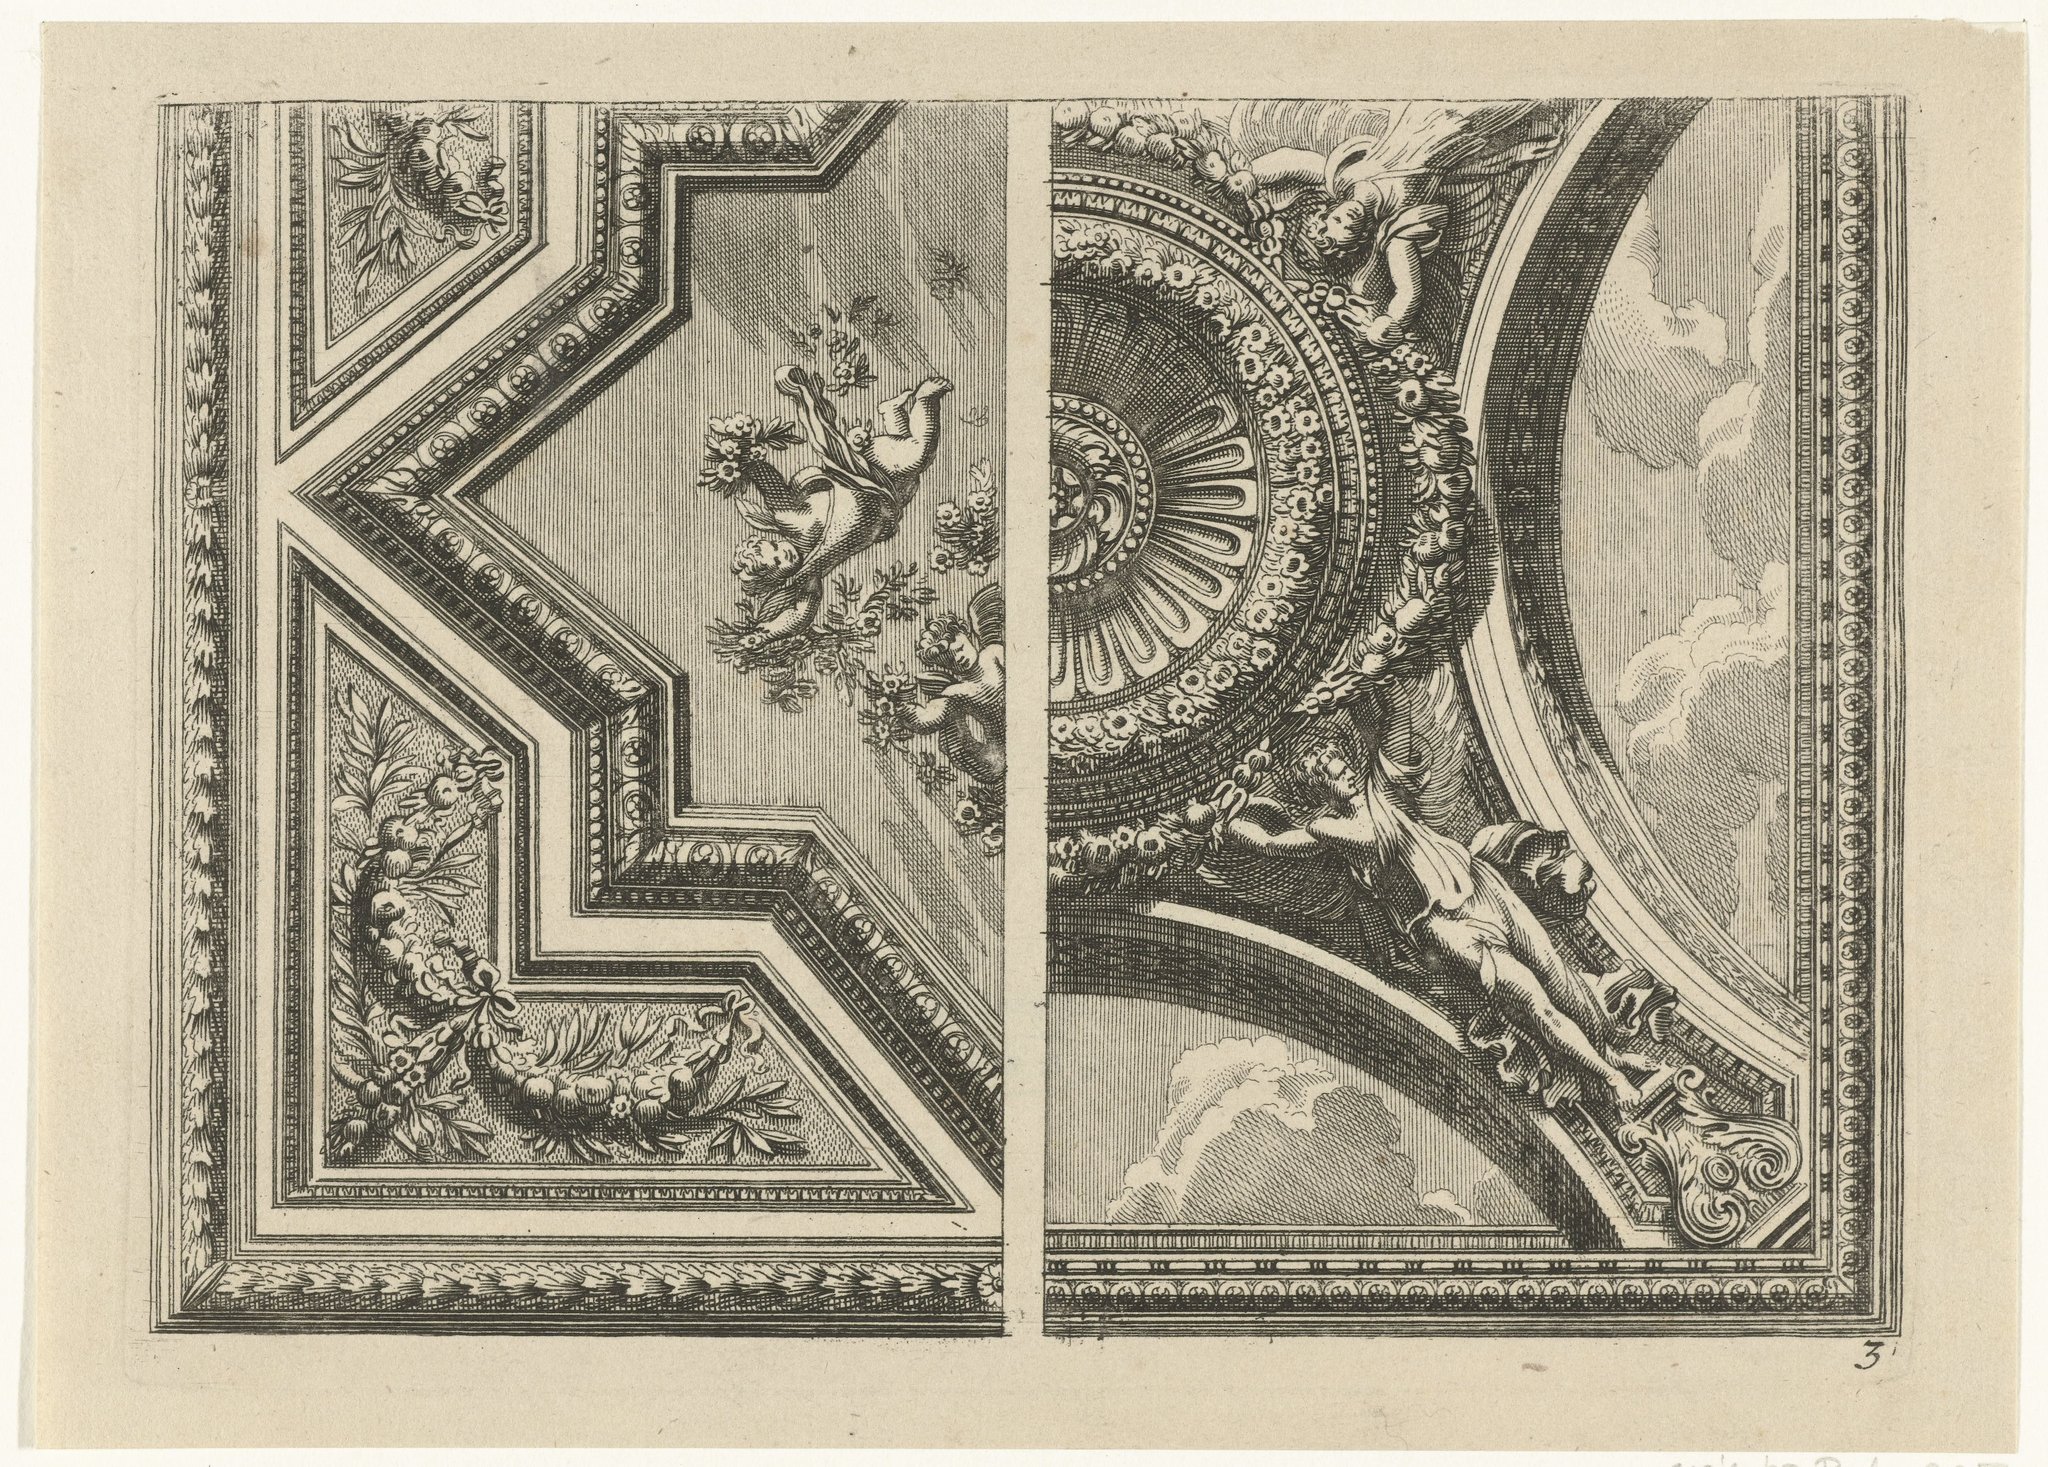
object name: print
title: Plafons A La Romaine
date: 1668-1716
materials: paper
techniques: etching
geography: france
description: Het linkerplafond is gedecoreerd met een dubbele guirlande van fruit en bladeren.